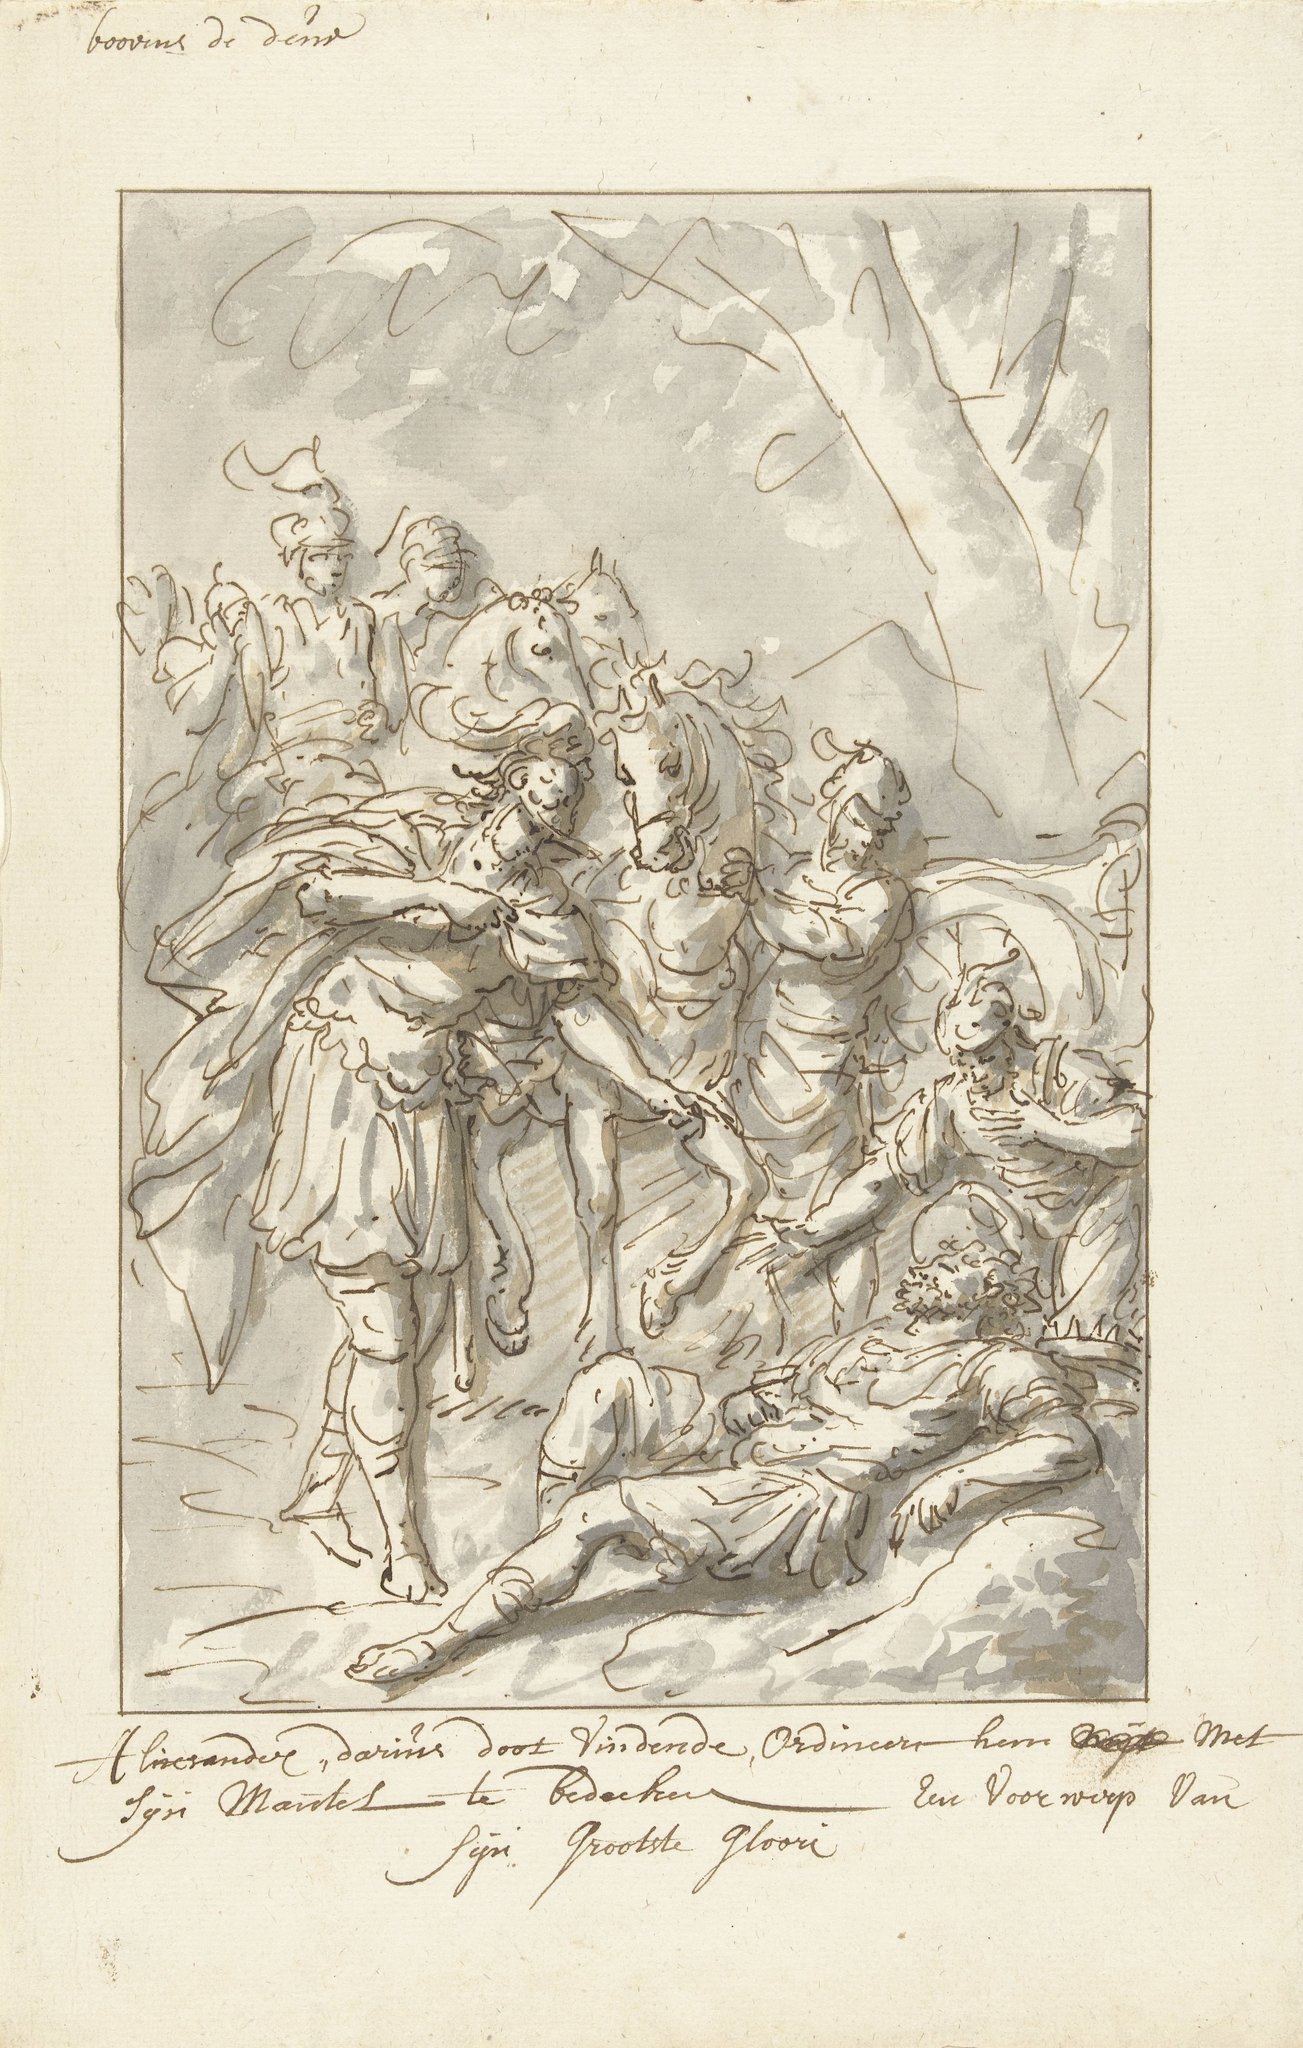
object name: design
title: Alexander de Grote bedekt het lijk van Darius met zijn mantel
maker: elias van nijmegen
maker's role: draughtsman, painter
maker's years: 1667-1755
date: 1677-1755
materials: ink, paper, pencil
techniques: brush, pen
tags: alexander covers darius' body with his own mantle